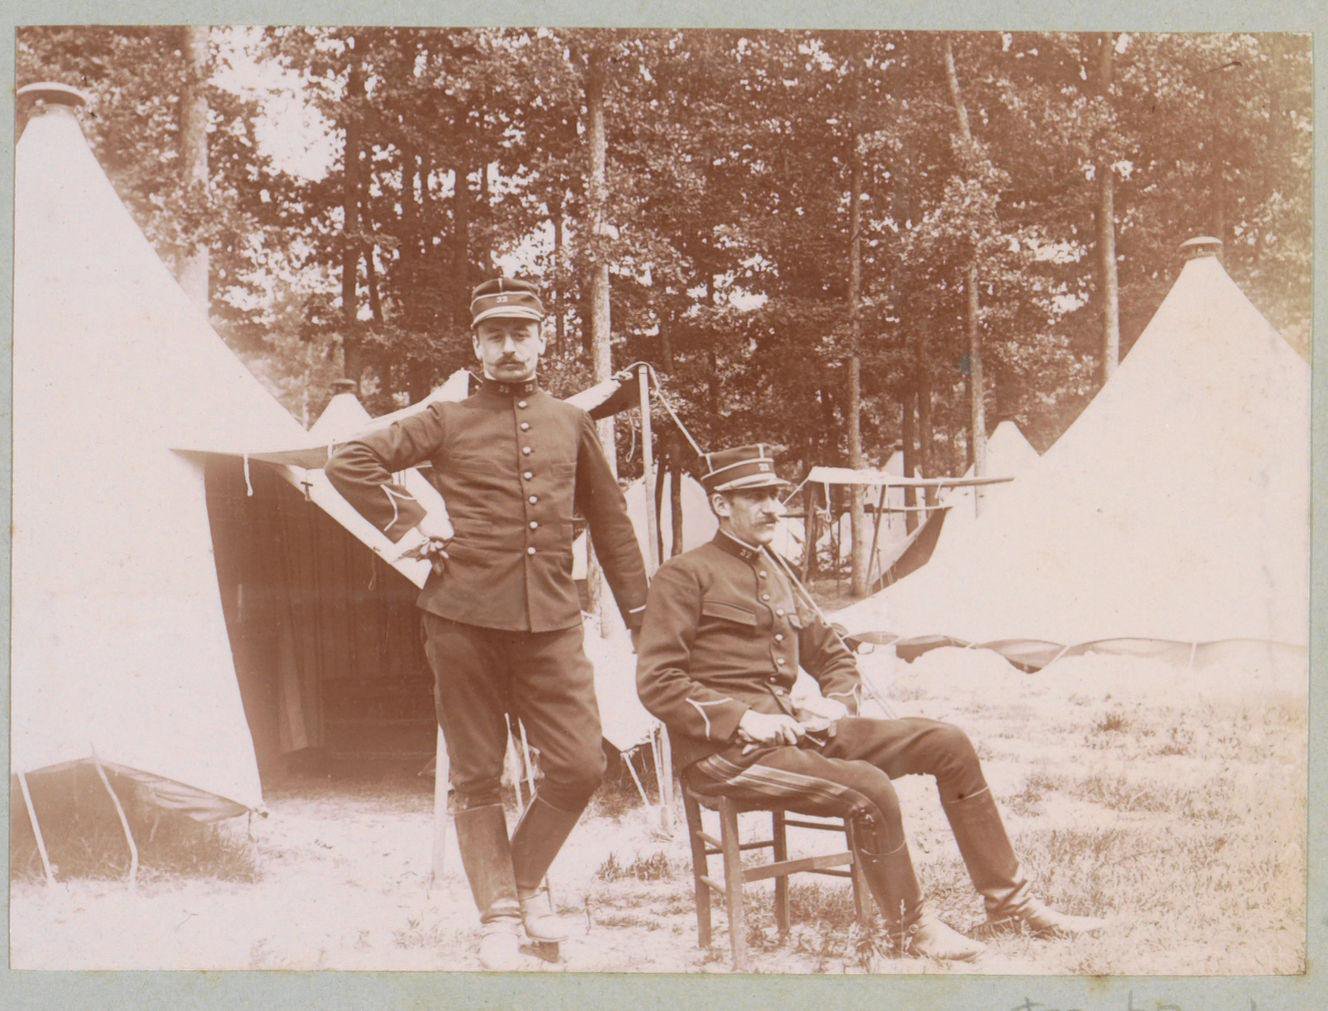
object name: photograph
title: Twee militairen in een legerkamp te Fontainebleau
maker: delizy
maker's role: manufacturer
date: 1806-1896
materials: paper, photographic support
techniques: gelatin silver print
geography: fontainebleau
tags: land forces (+ cavalry, horsemen), (military) camp with tents, (military) uniforms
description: Onderdeel van Fotoalbum van een Franse amateurfotograaf met opnames van uitstapjes in Frankrijk, Spanje, België, Luxemburg en Nederland, de eerste automobielen en autoraces.